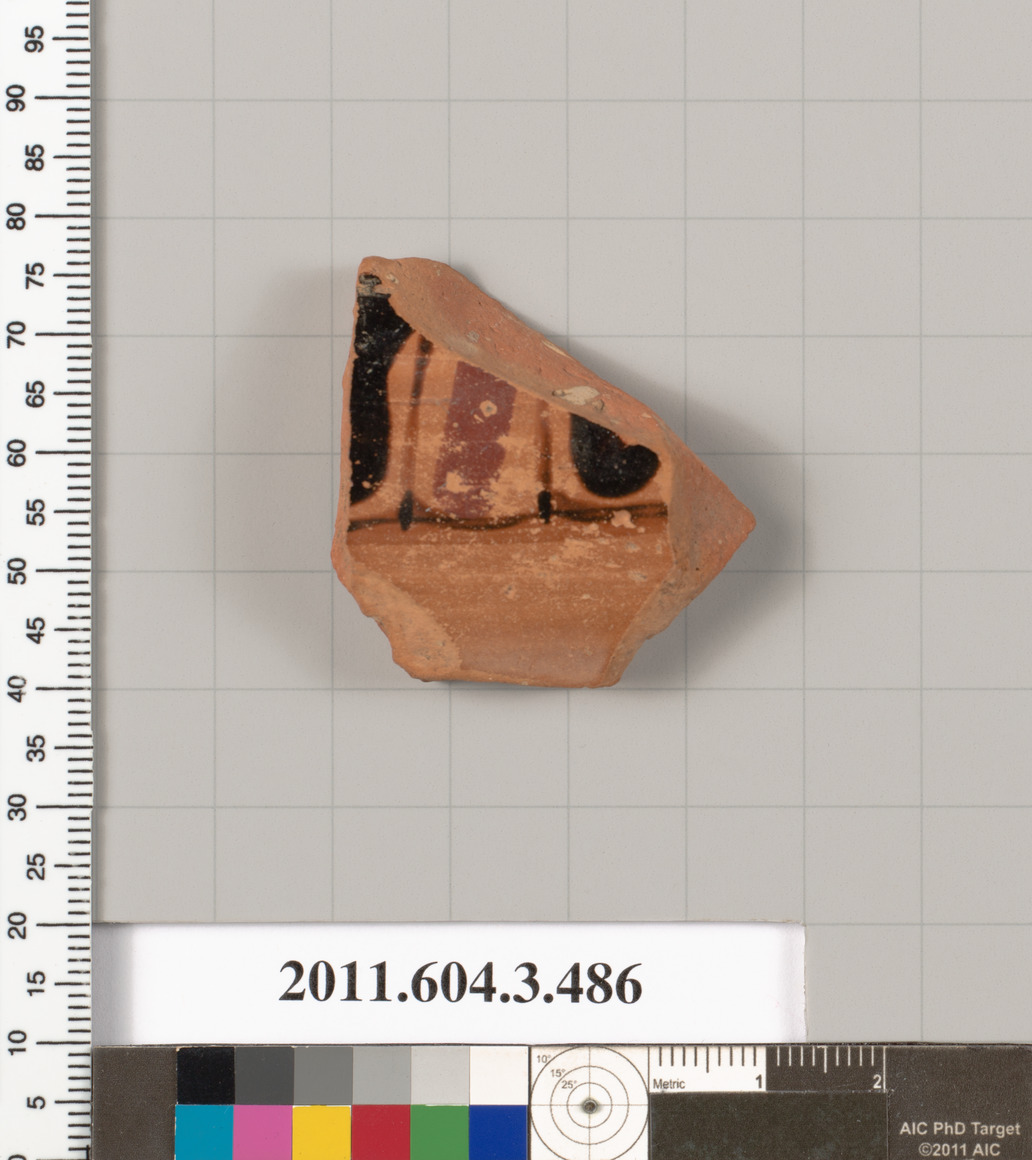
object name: column krater fragment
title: Terracotta fragment of a column-krater (bowl for mixing wine and water)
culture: greek, attic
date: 567-535 BCE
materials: terracotta